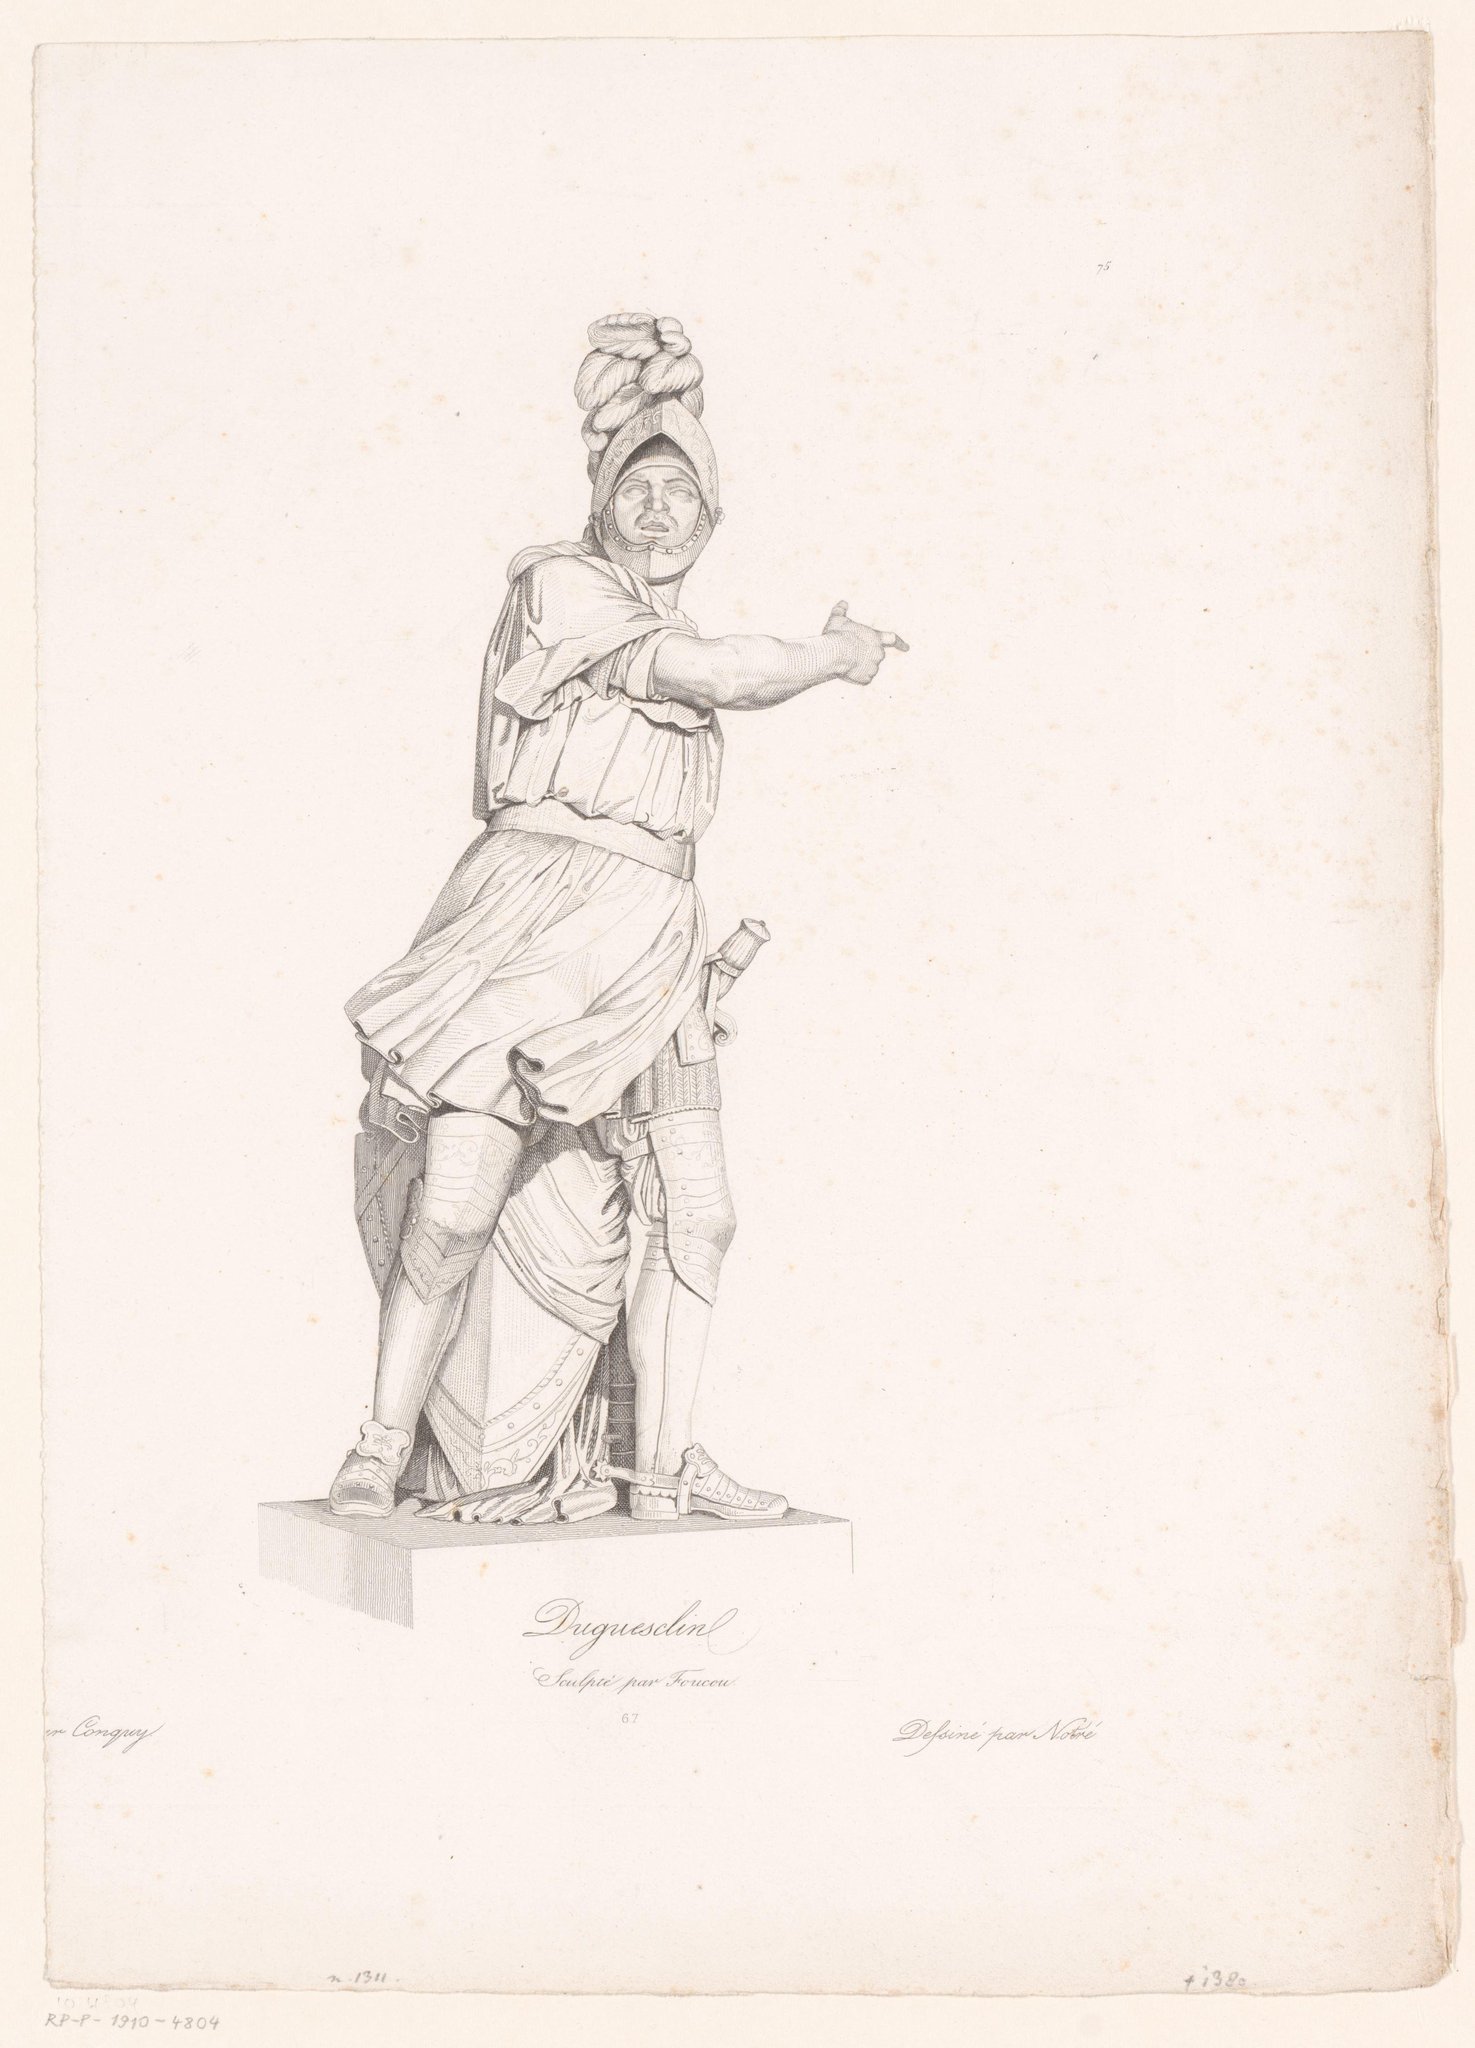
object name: book illustration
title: Portret van Bertrand du Guesclin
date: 1838-1841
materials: paper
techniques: engraving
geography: france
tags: armour, historical persons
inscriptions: collector's mark: Lugt 2228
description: Prent uit: Galeries historiques de Versailles. Parijs: Charles Gavard, 1838-1841.